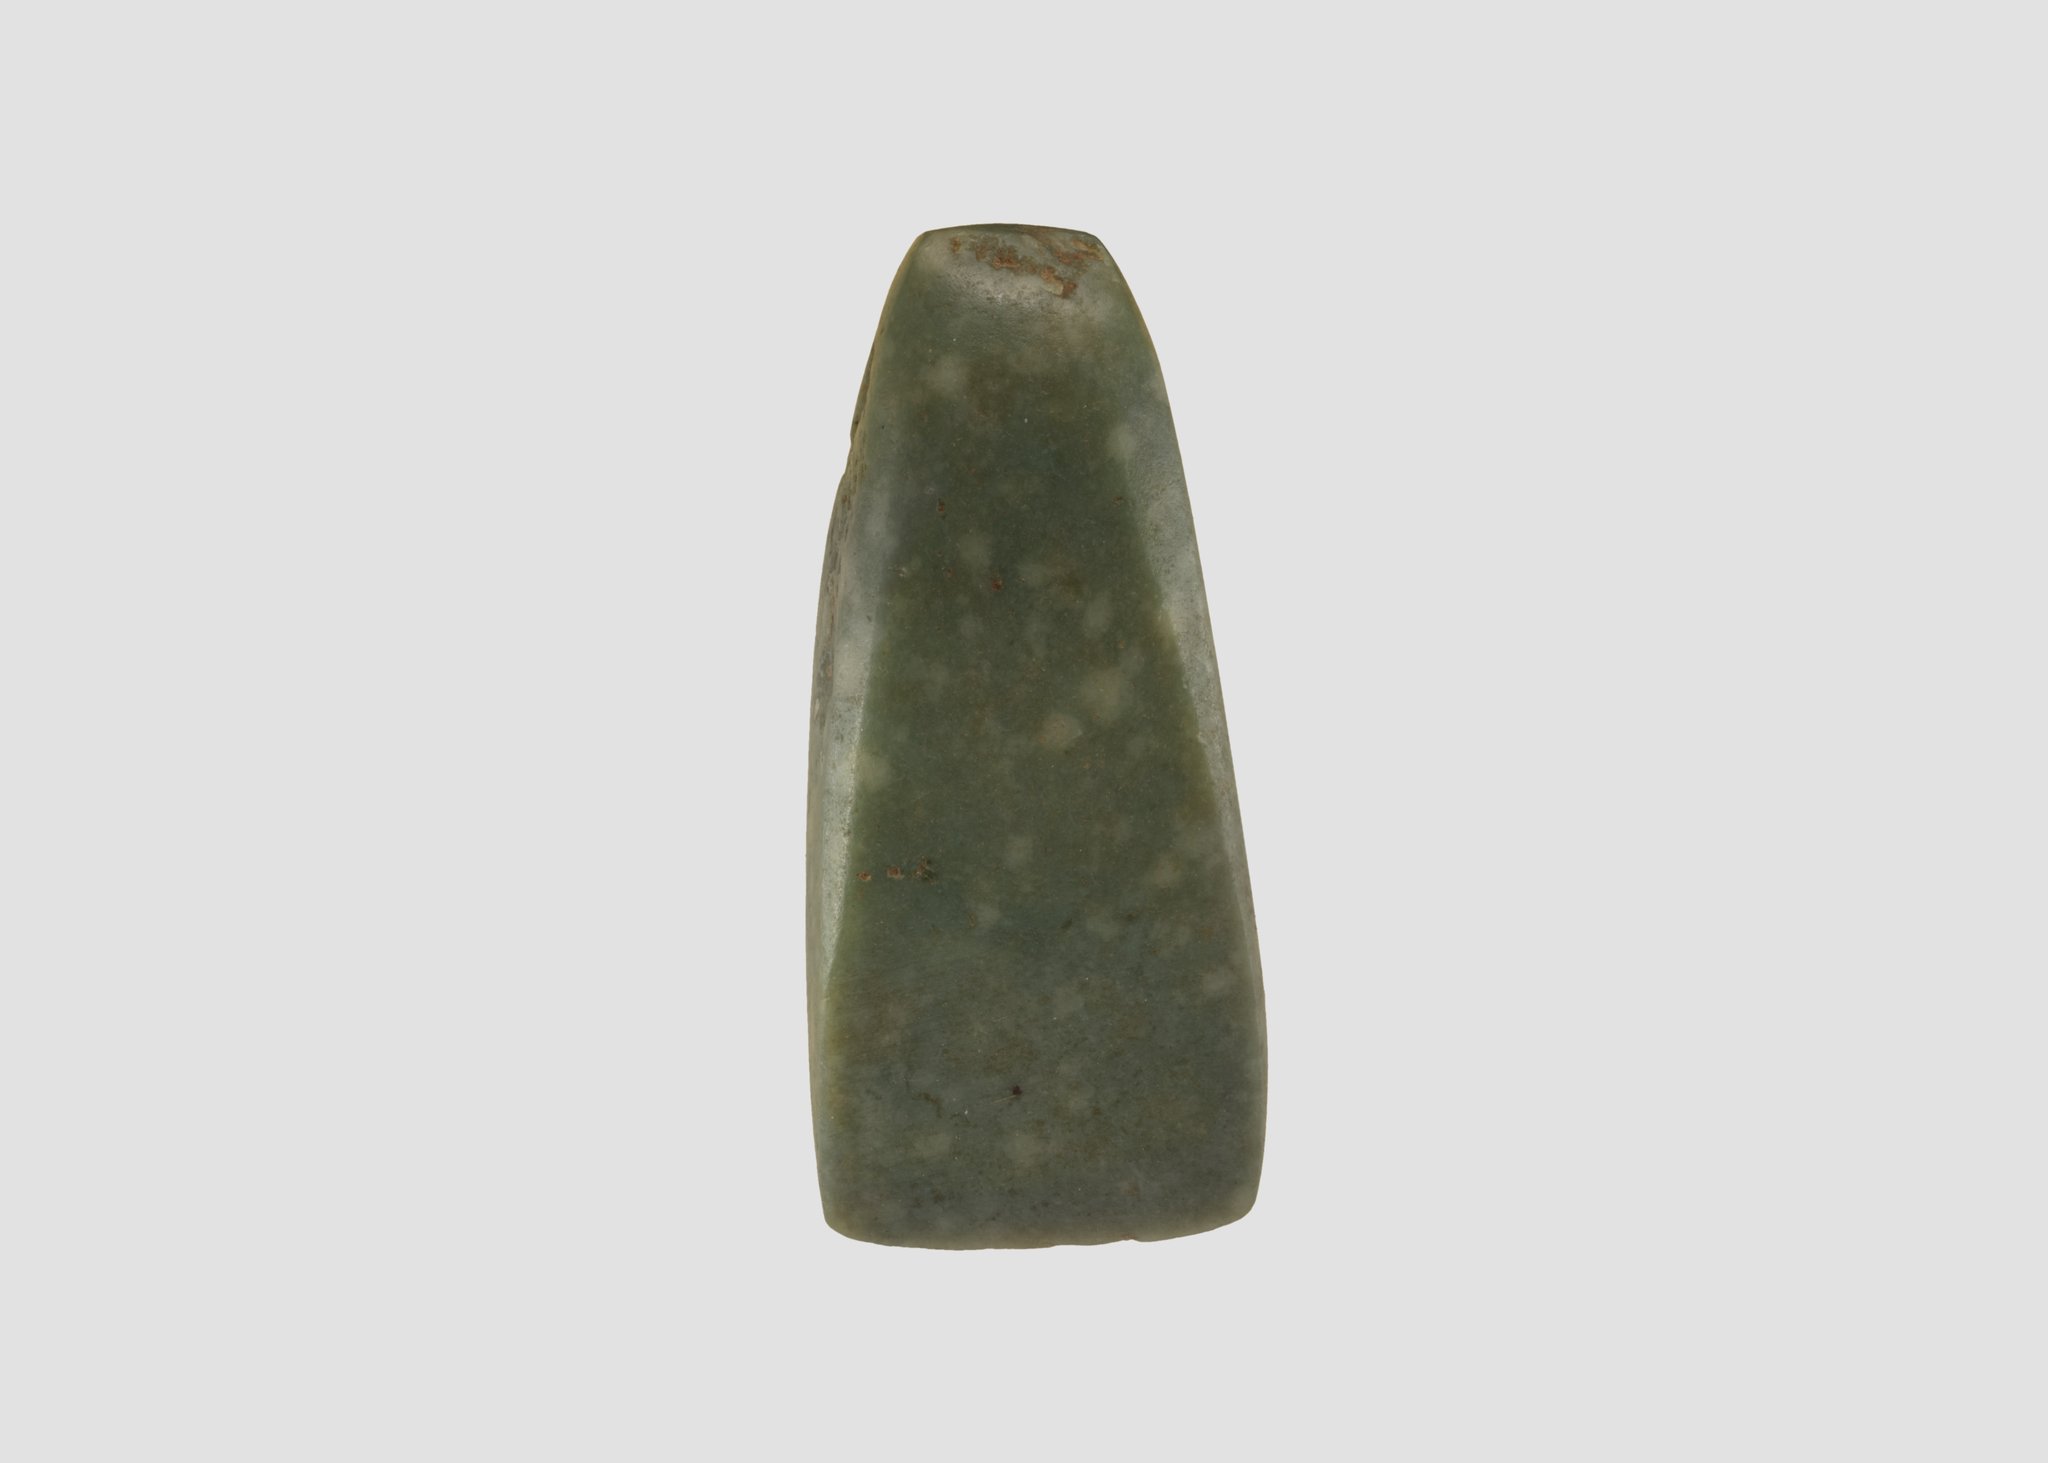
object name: celt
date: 7000-5001 BCE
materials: stone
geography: syria